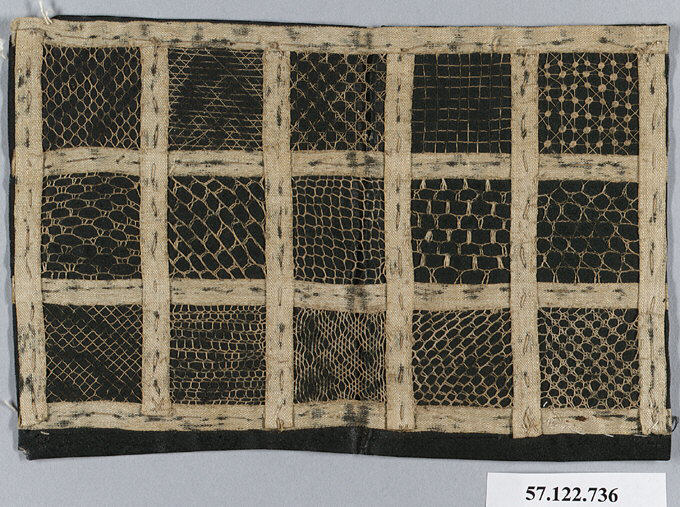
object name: sampler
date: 1801-1900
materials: linen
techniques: lace